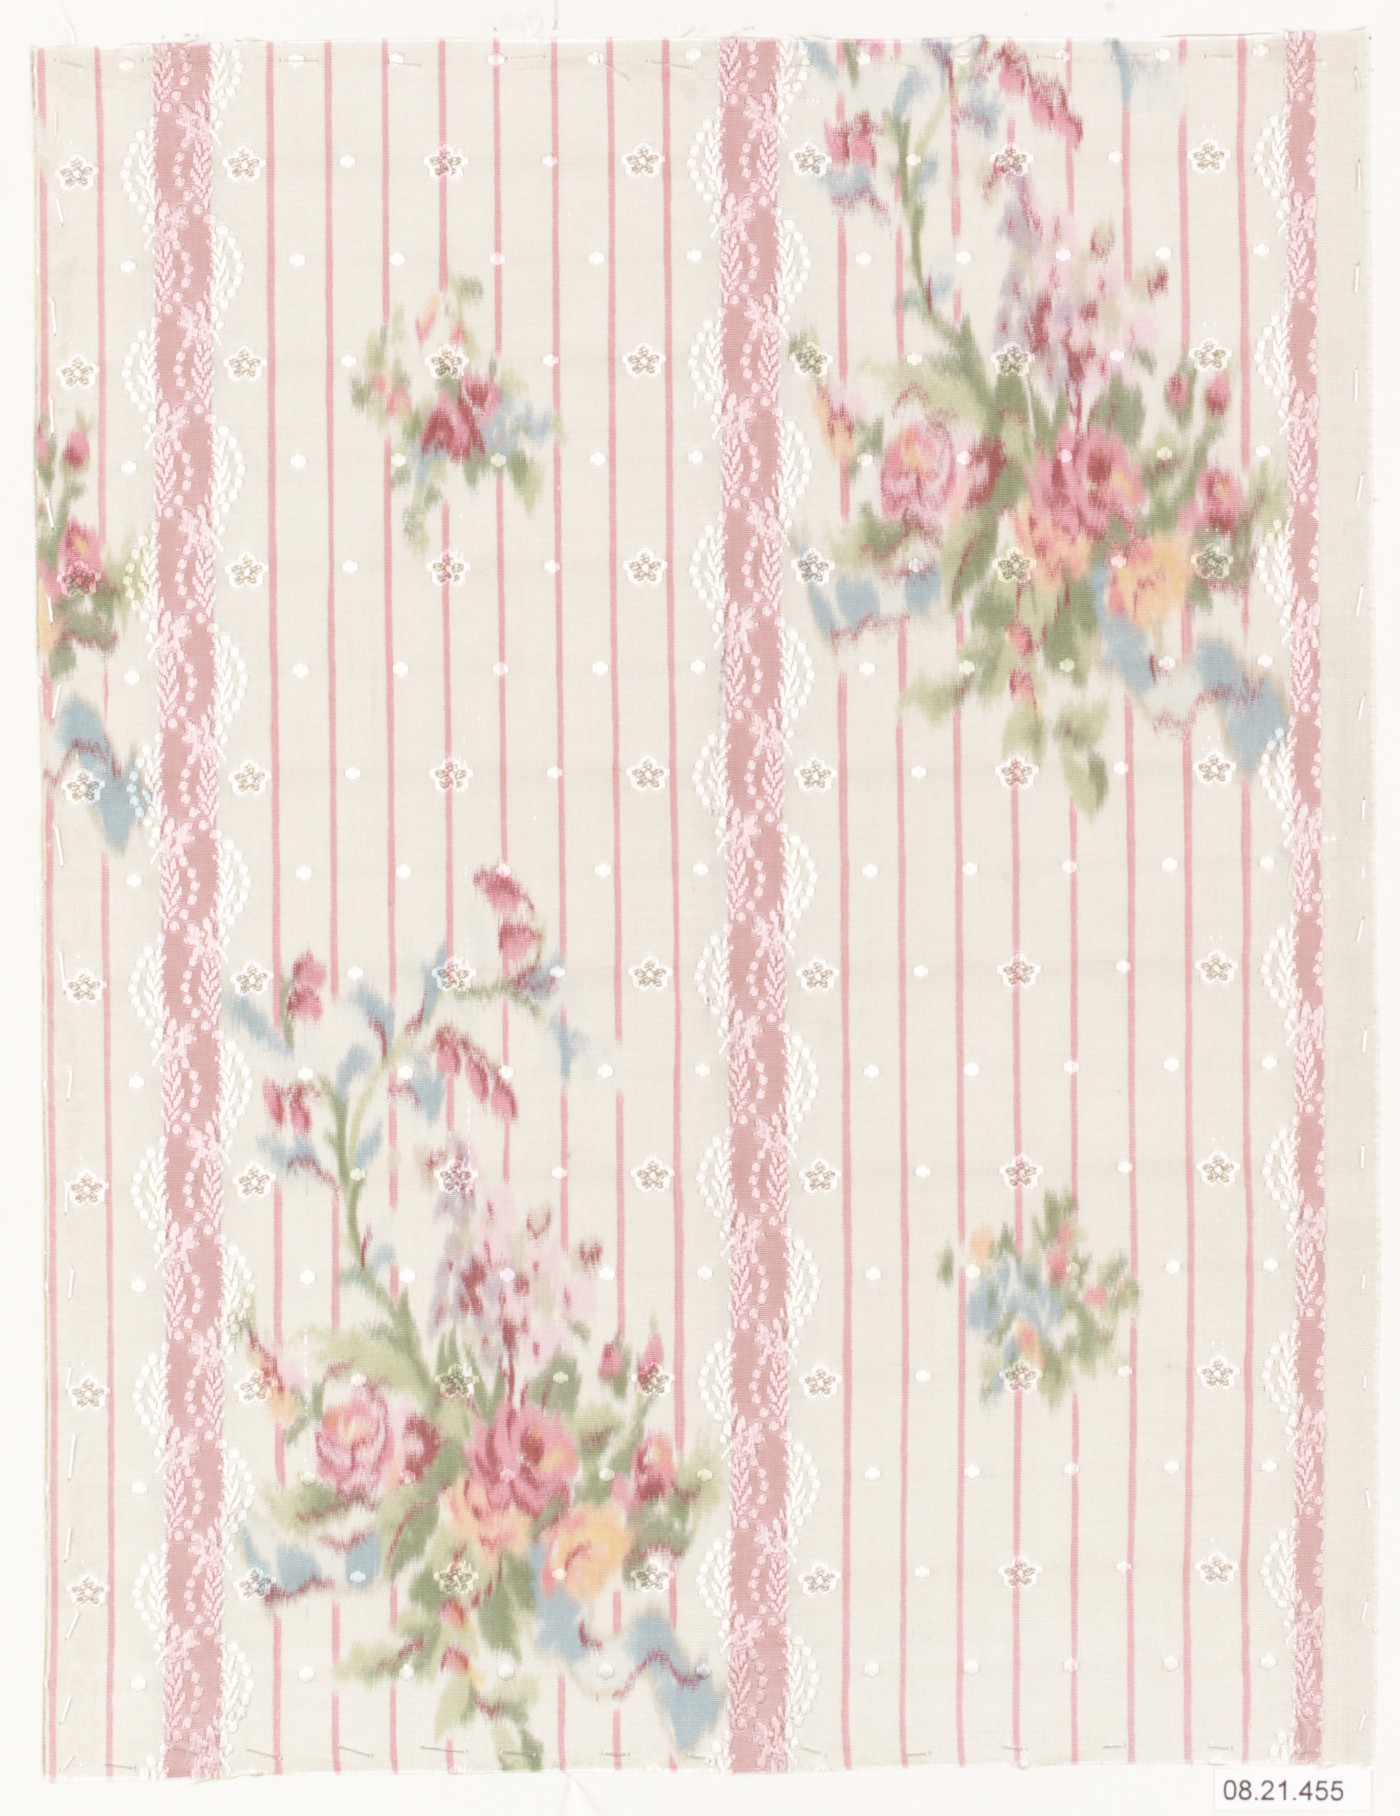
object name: textile sample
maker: Anonymous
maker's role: designer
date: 1900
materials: silk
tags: flowers